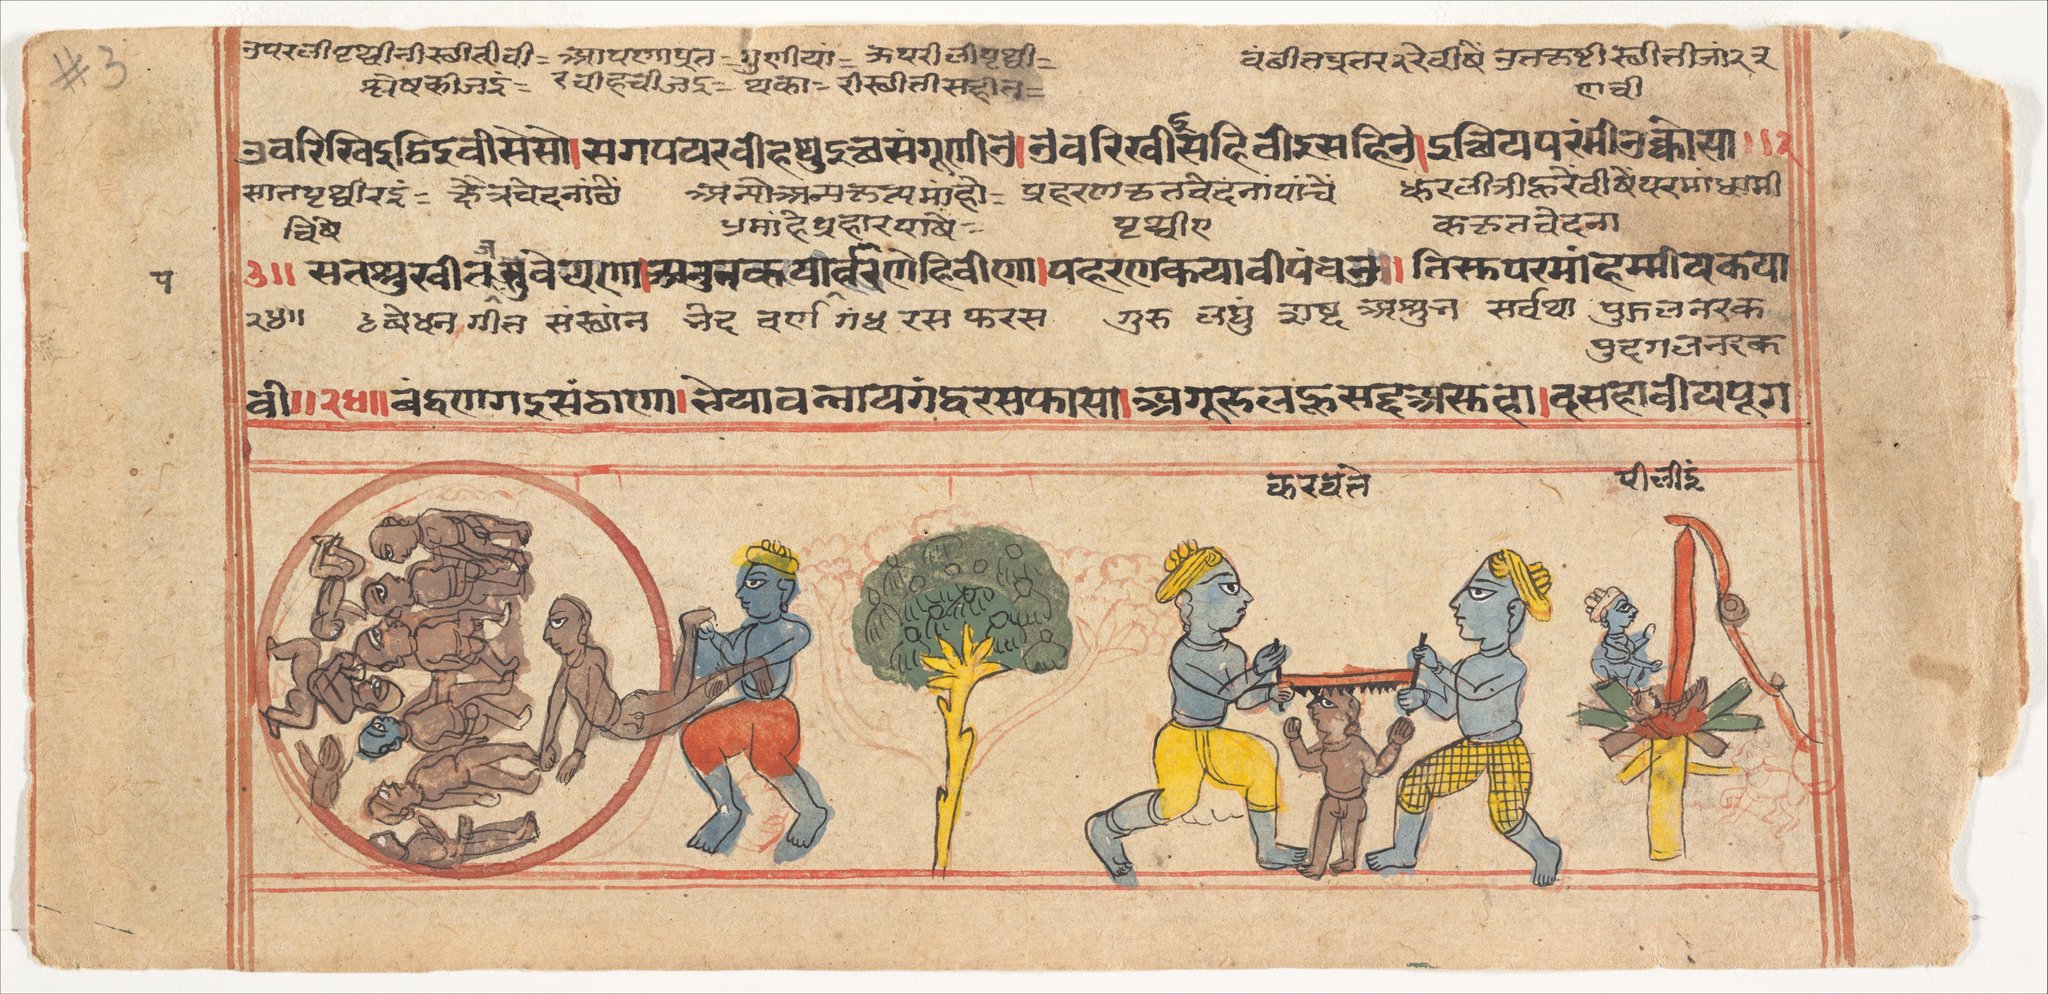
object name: folio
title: Tortures of the Damned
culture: indian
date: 1800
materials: ink, paper, watercolor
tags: men